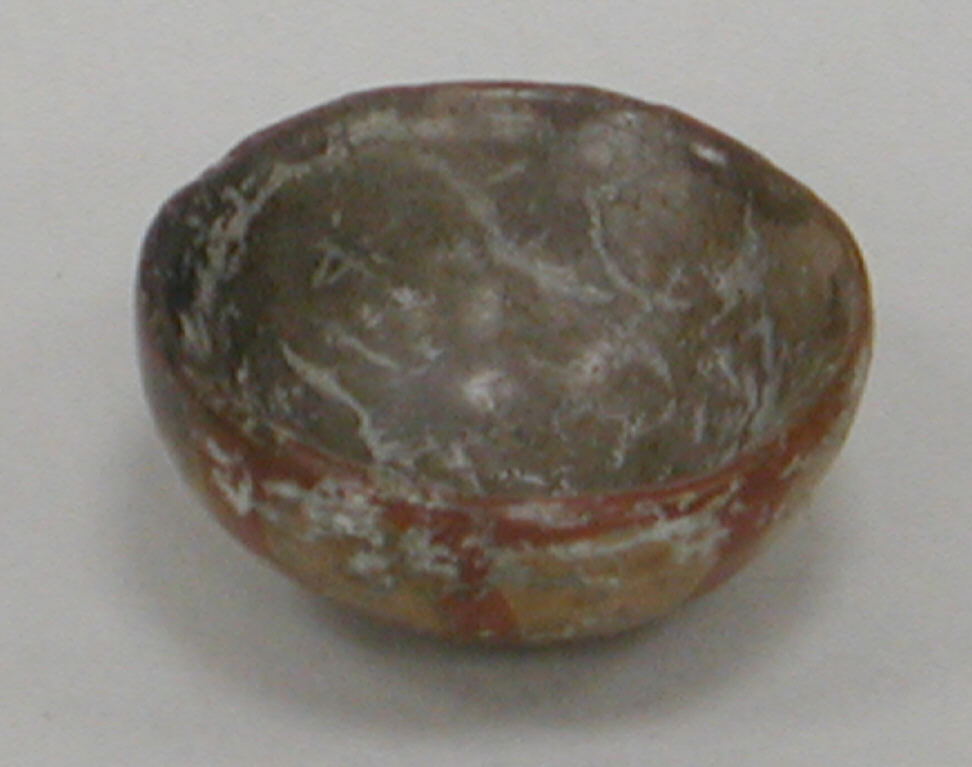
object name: bowl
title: Miniature Painted Bowl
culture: mexica, aztec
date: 1401-1533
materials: ceramic, pigment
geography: mexico